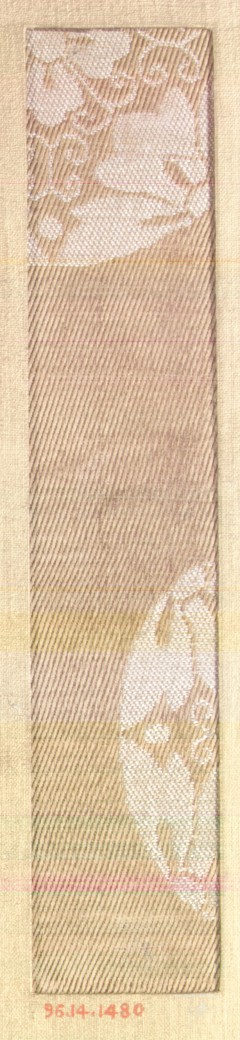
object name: piece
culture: japanese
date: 1701-1900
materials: silk